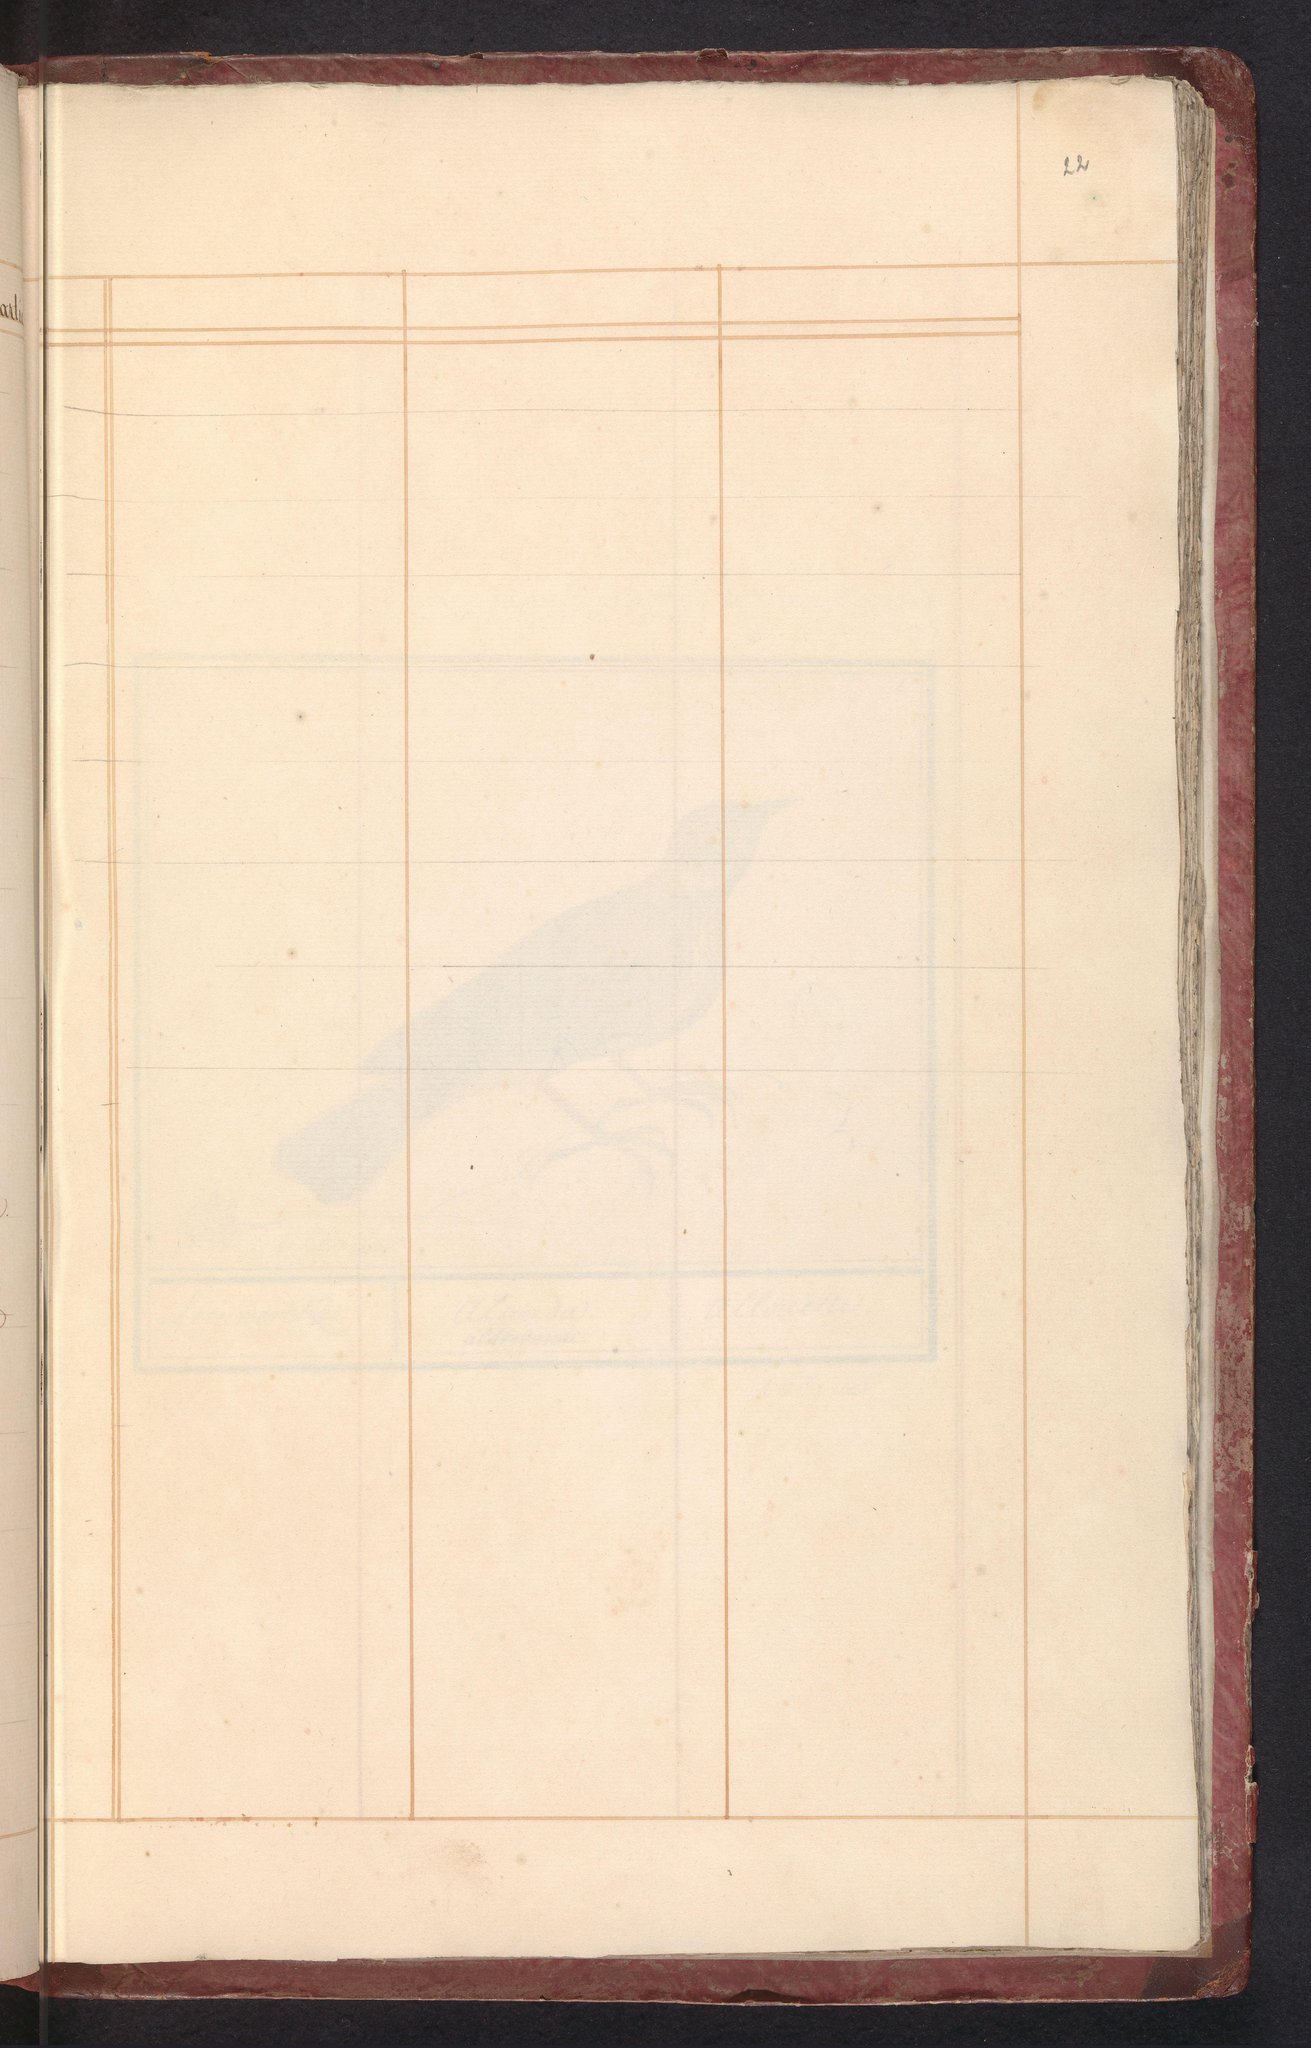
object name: manuscript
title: Oningevuld schema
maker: joseph van huerne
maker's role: kunstliefhebber, mecenas, verzamelaar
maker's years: 1752-1844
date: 1809-1814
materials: ink, paper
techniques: handwriting, pen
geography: bruges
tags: handwriting, written text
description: Oningevuld schema met drie kolommen. Onderdeel van het tweede album met tekeningen van vogels. Vierde van twaalf albums met tekeningen van dieren, vogels en planten bekend rond 1600, gemaakt in opdracht van keizer Rudolf II. Met toelichting in Nederlands, Latijn en Frans.